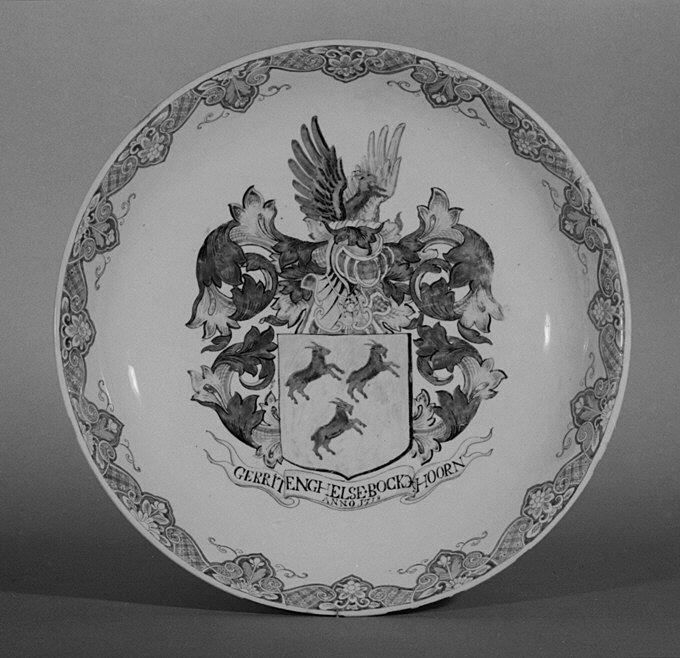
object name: plate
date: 1718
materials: hard paste porcelain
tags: birds,goats,coat of arms